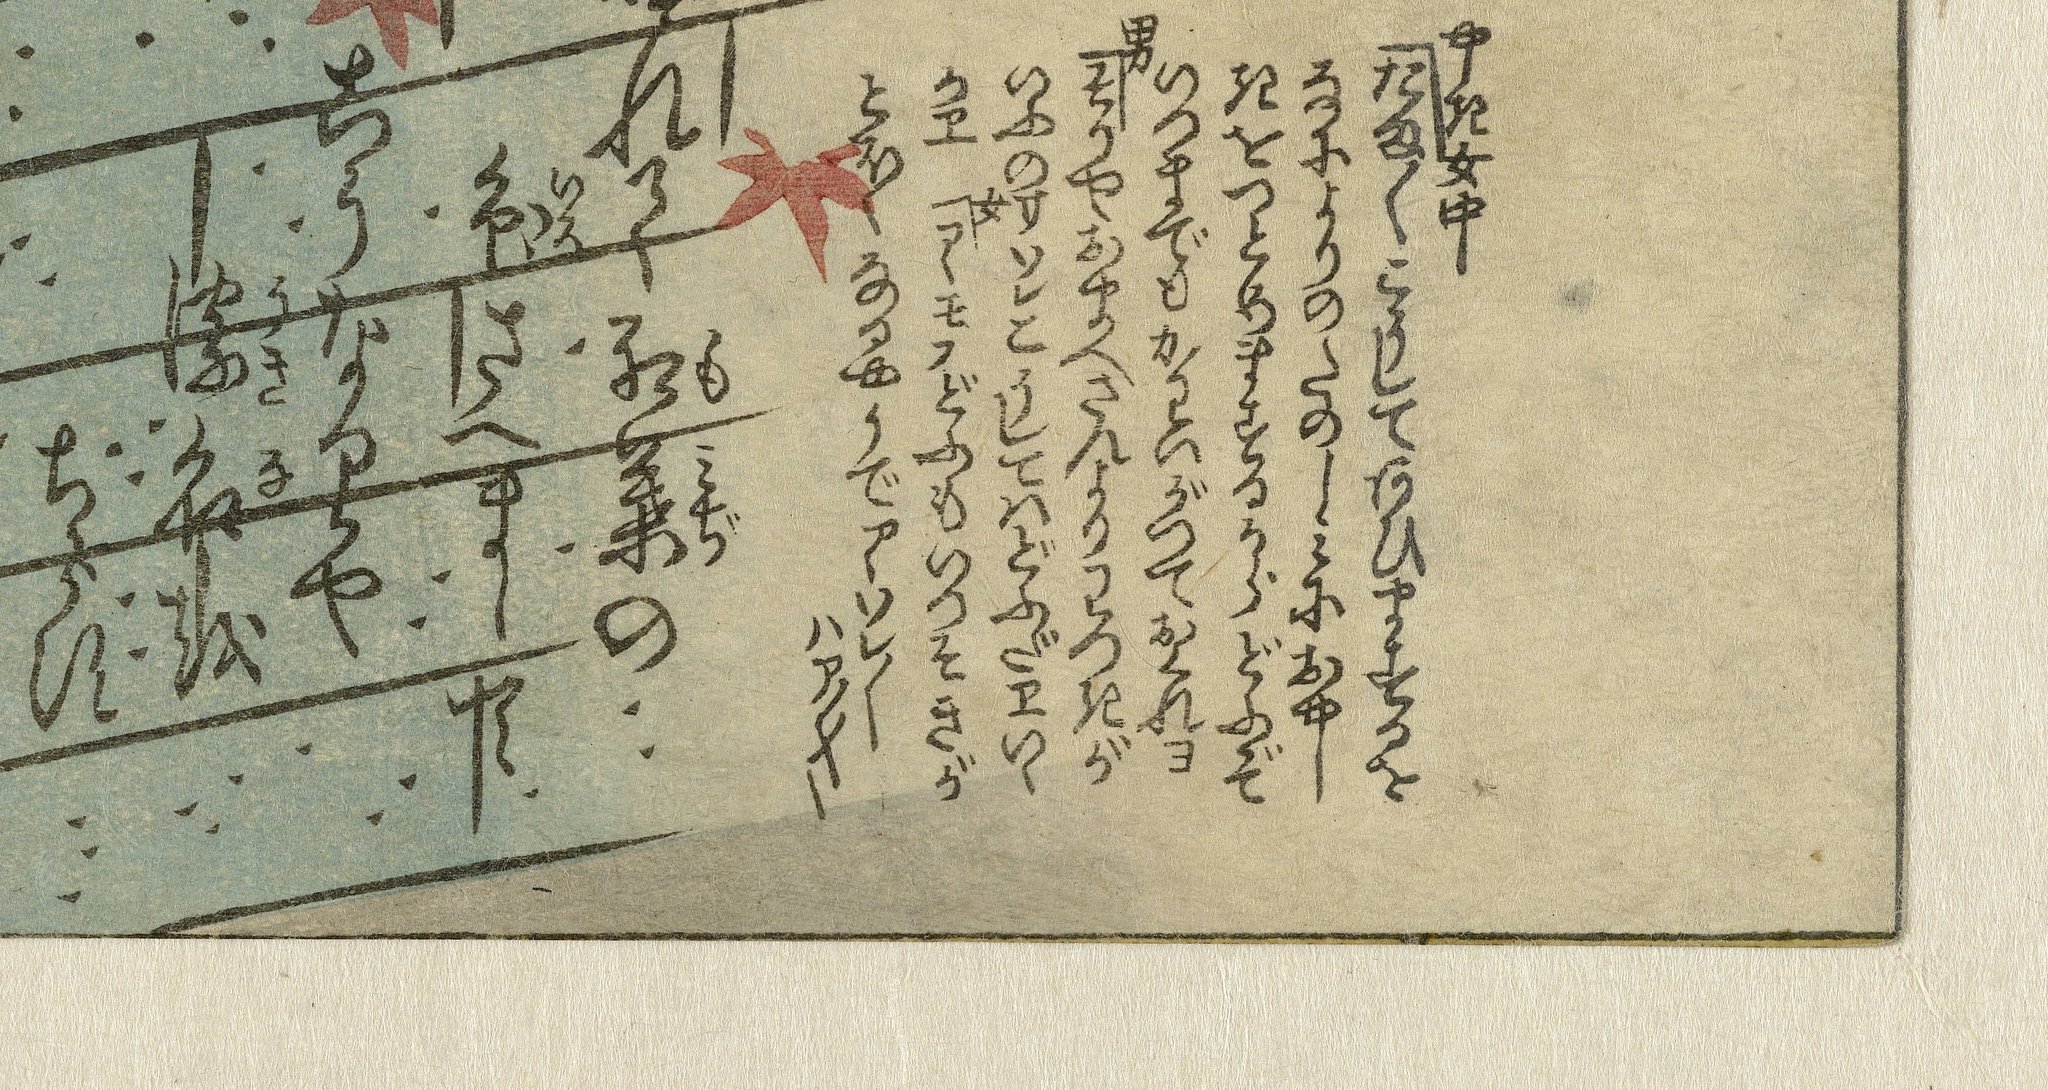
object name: print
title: Muur en acerbladeren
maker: Anonymous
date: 1850-1860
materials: paper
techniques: woodcut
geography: japan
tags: fence, wall, paling, oriental ideographic script (chinese, korean, japanese)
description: Een blauwe muur met vallende acerbladen, met een begleidende tekst bij de 'hoge rang waaier'.